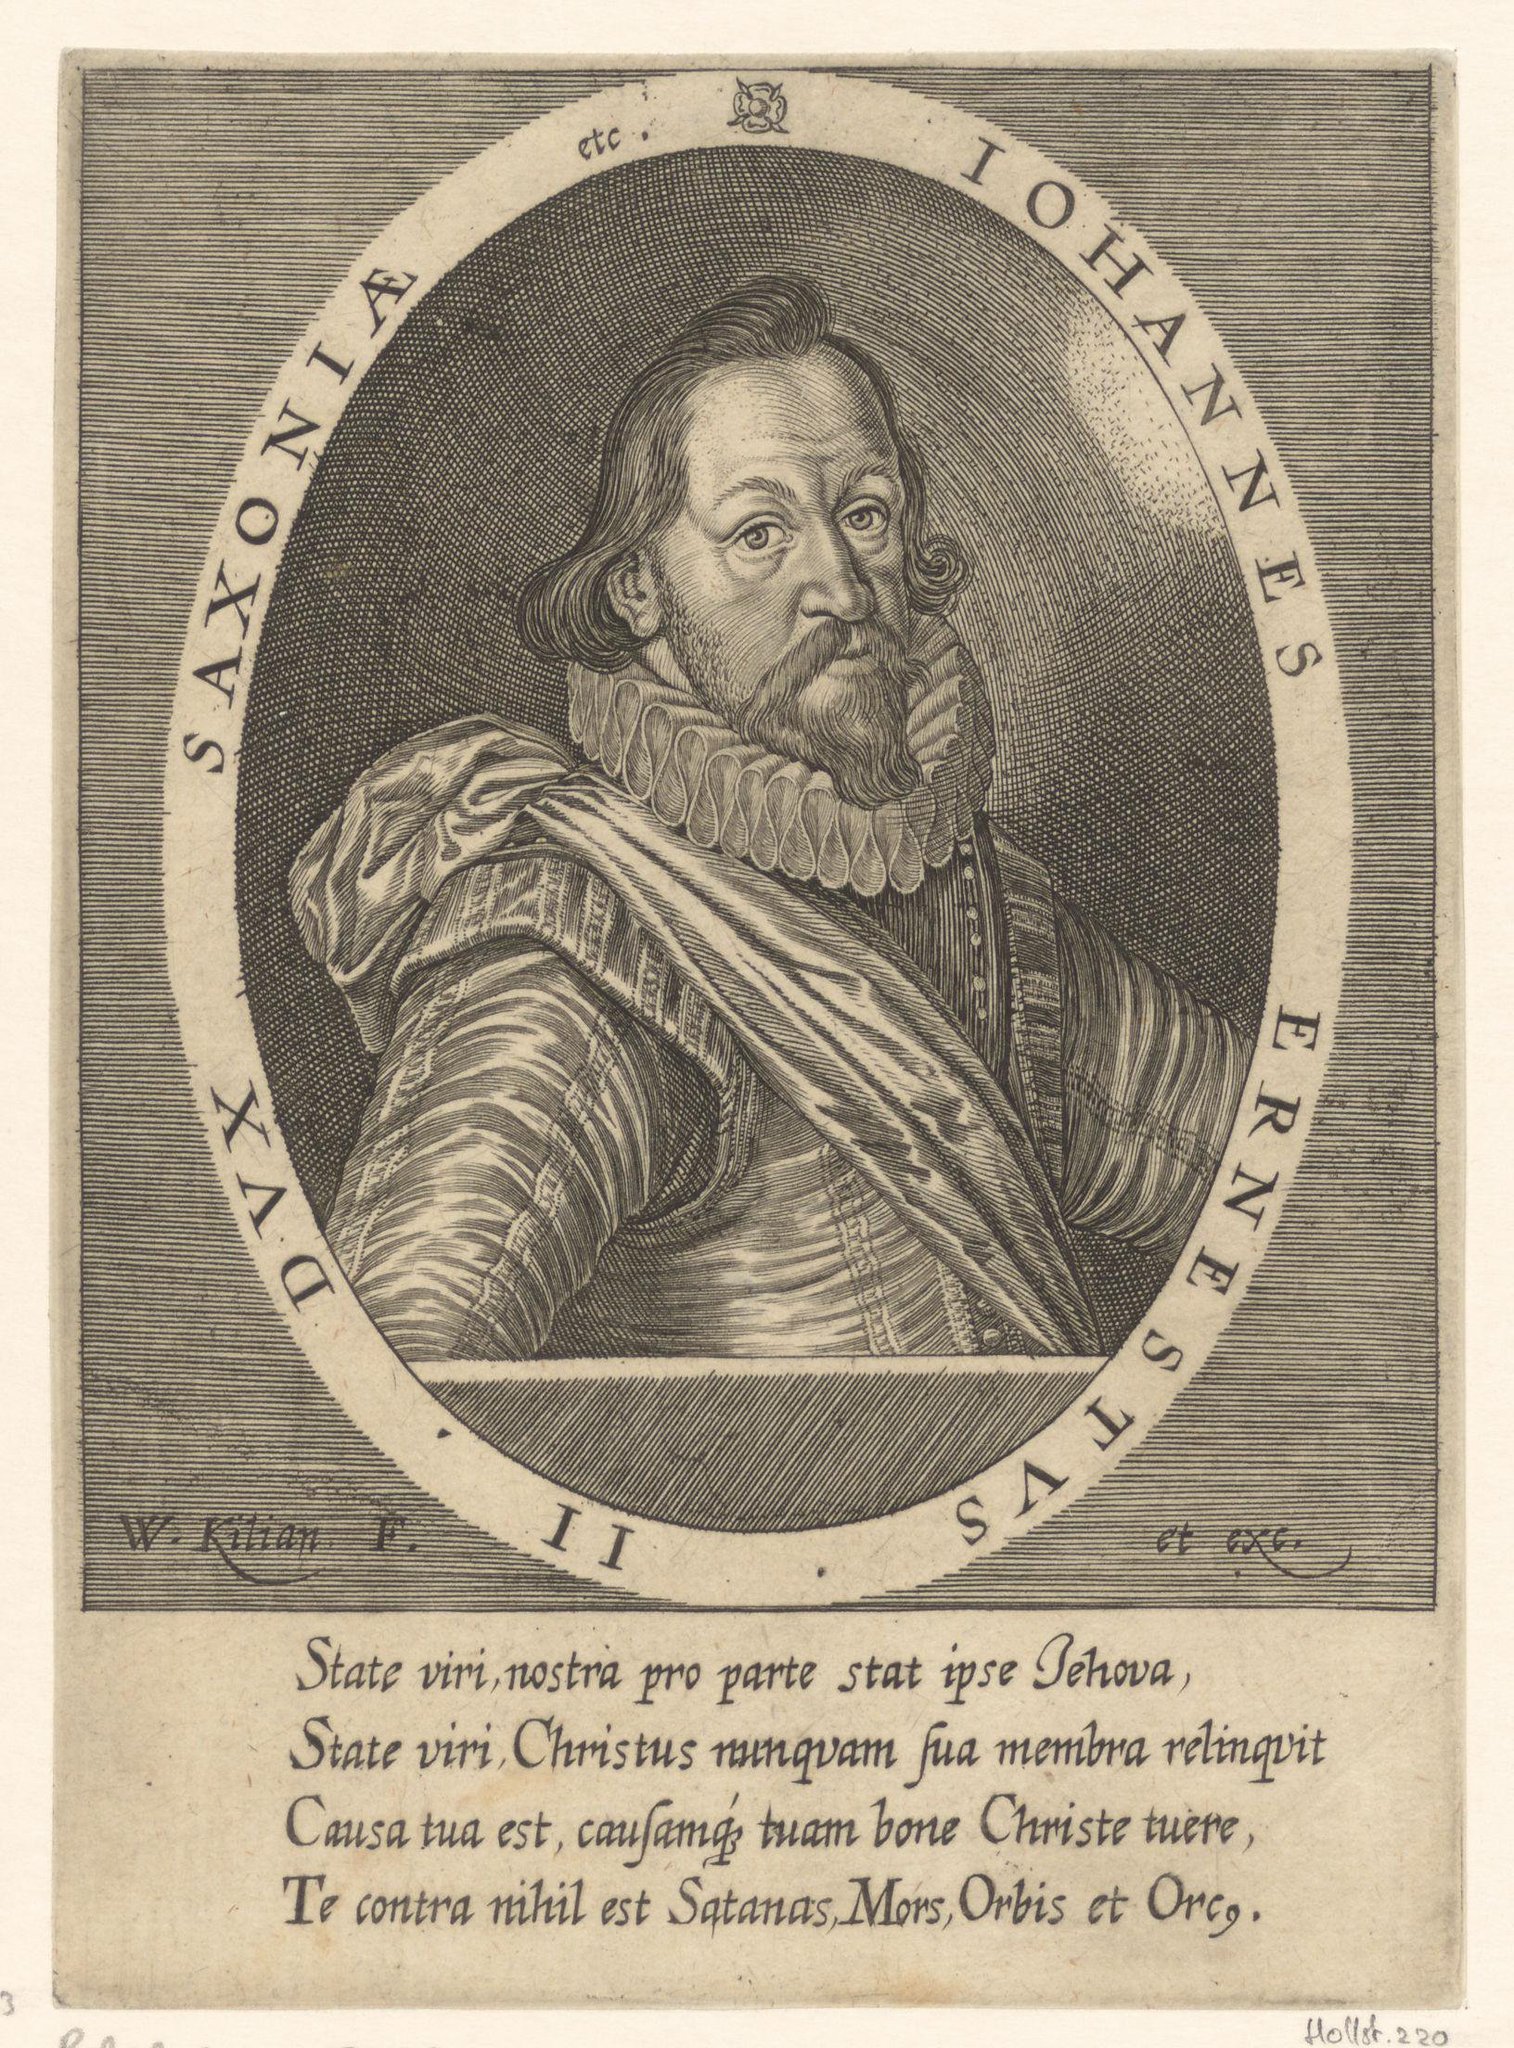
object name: print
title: Portret van Johann Ernst van Saksen-Weimar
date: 1637-1662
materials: paper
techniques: engraving, etching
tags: historical persons, regent, substitute ruler; viceroy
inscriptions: collector's mark: Lugt 2228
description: Tekst in het Latijn in de omlijsting en in de ondermarge.